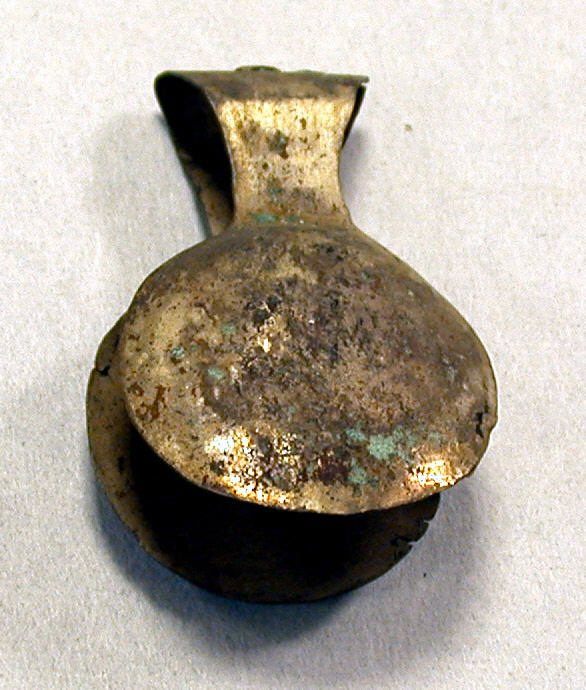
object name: tweezer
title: Hammered Silver Tweezers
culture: peruvian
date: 701-1566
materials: gilt, silver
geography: peru